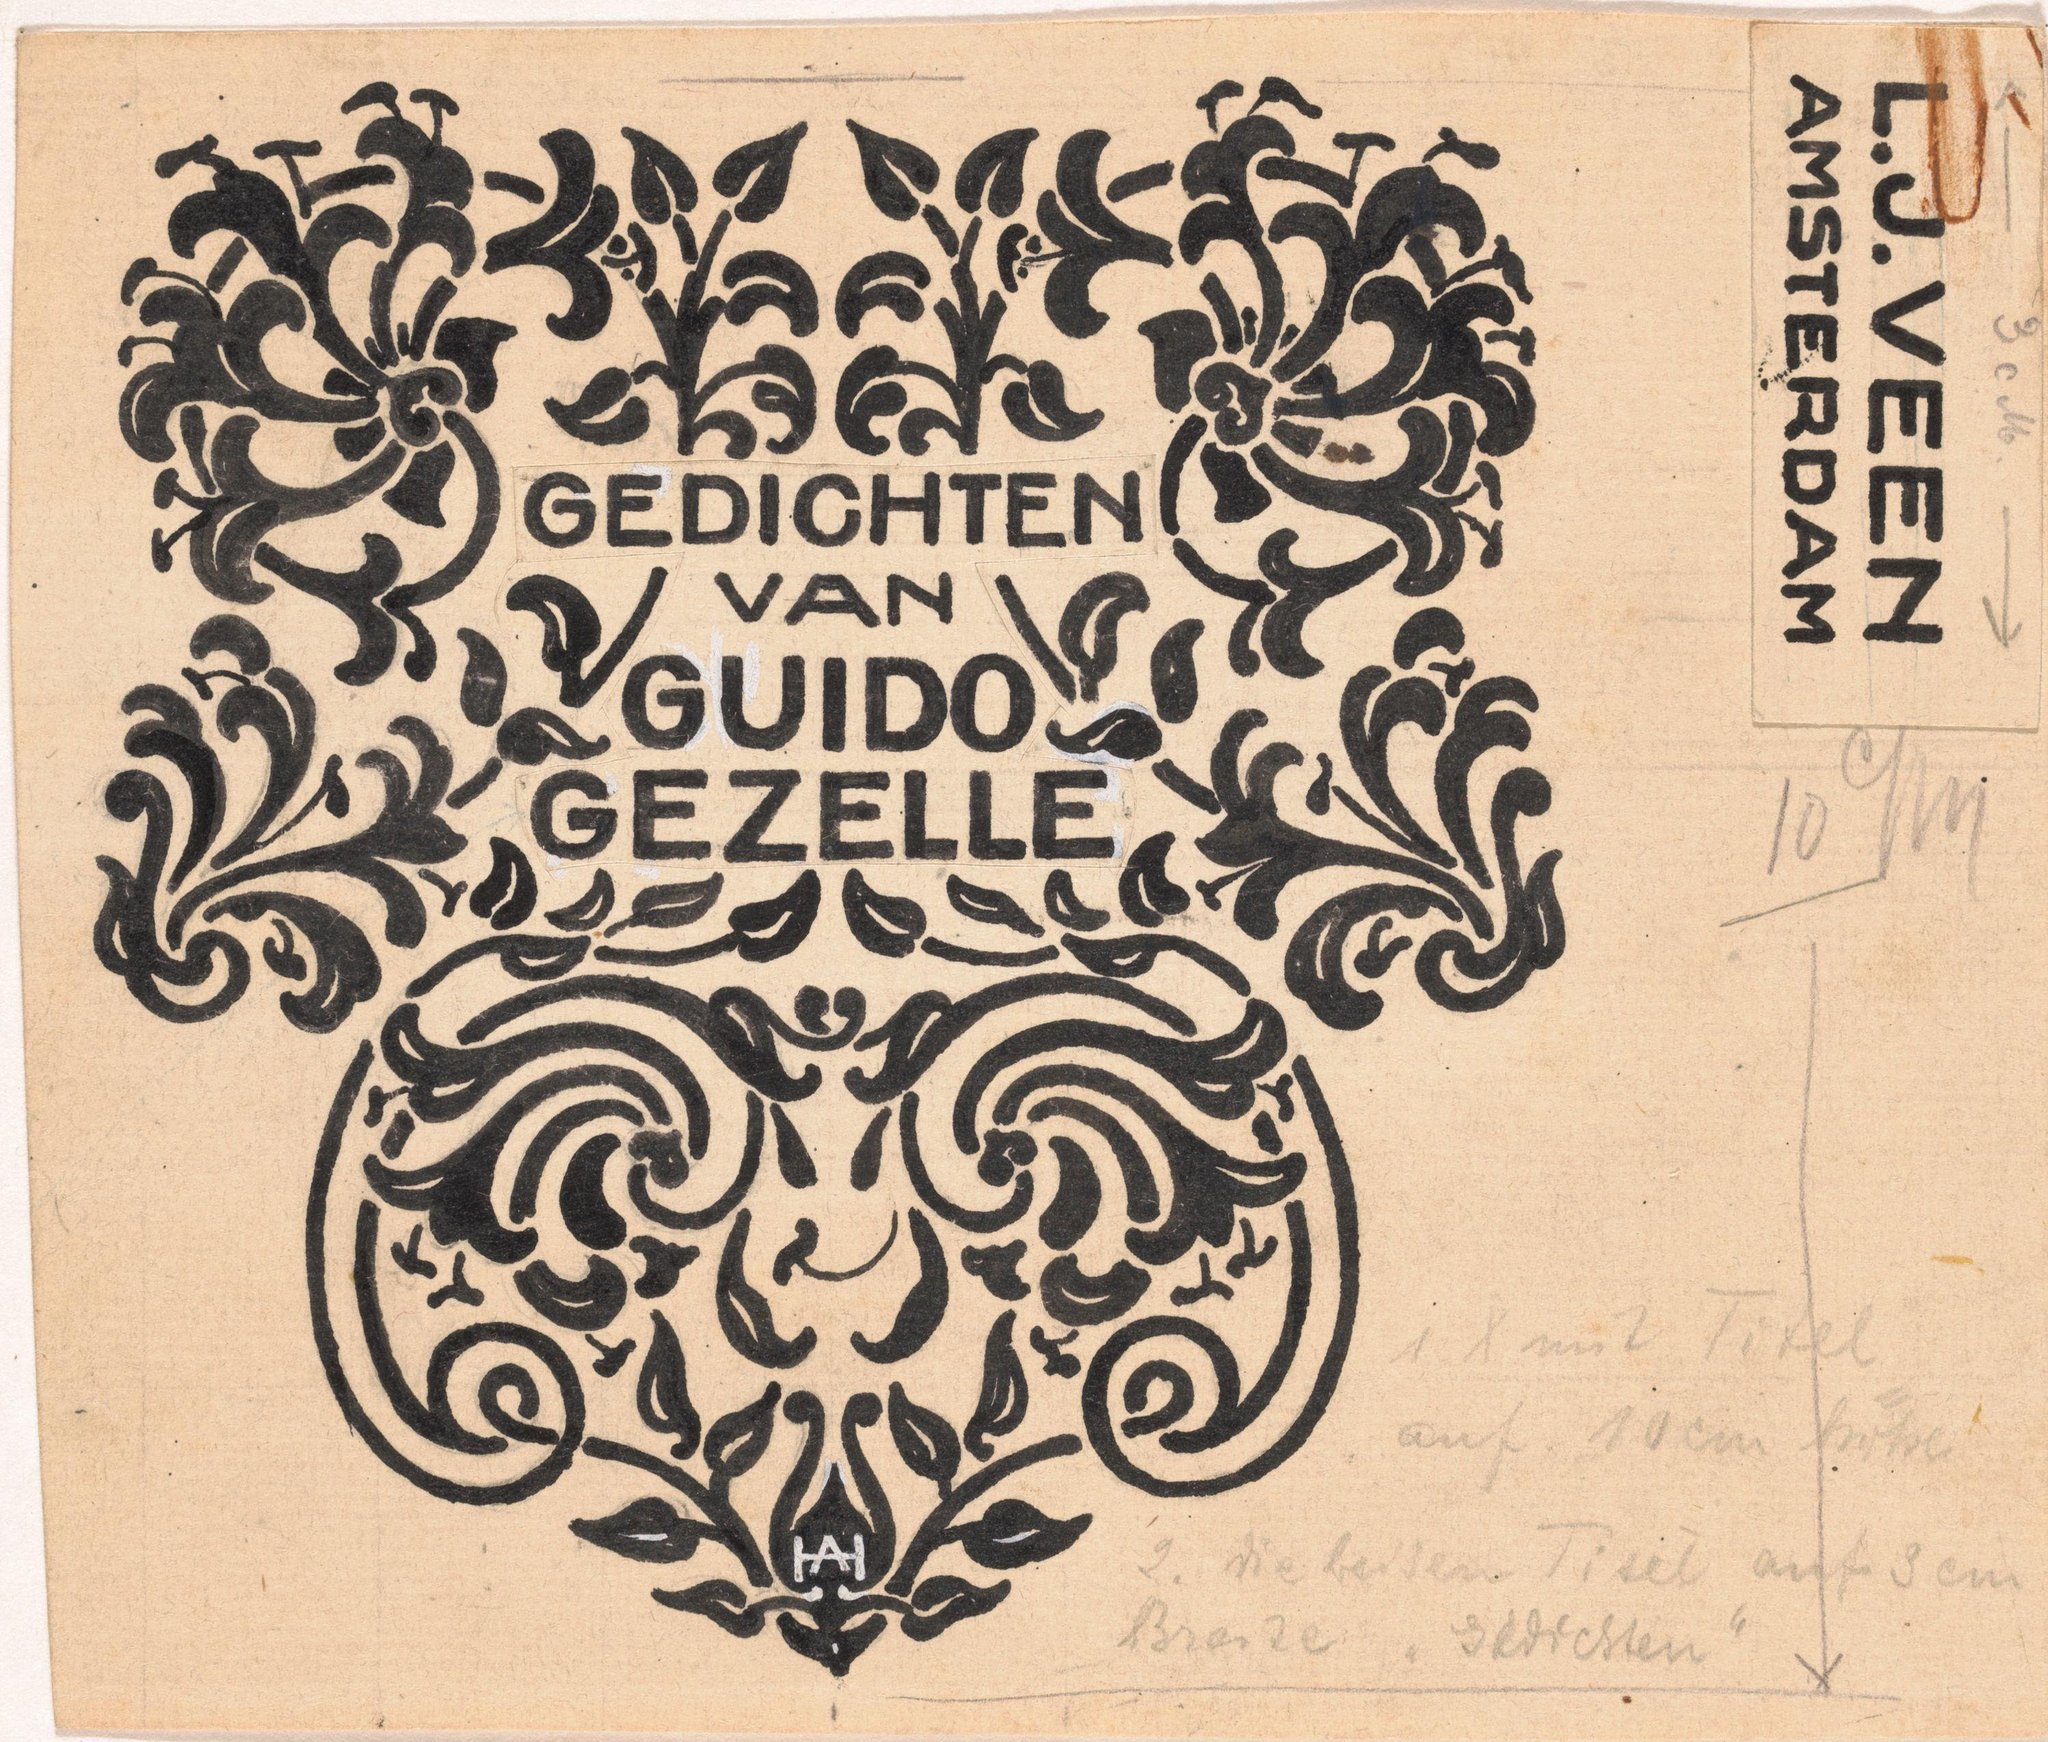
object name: drawing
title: Bandontwerp voor: Gedichten van Guido Gezelle, jaar onbekend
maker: albert hahn (ii)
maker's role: draughtsman, print maker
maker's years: 1894-1953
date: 1904-1953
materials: paint, ink, paper, pencil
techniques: brush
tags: foliage, tendrils, branches ~ ornament, flowers ~ ornament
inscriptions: :, collector's mark: Lugt 2228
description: Ontwerp voor een bandstempel met rondom de boektitel een ornament bestaande uit bloemen, bladeren en krullende lijnen.